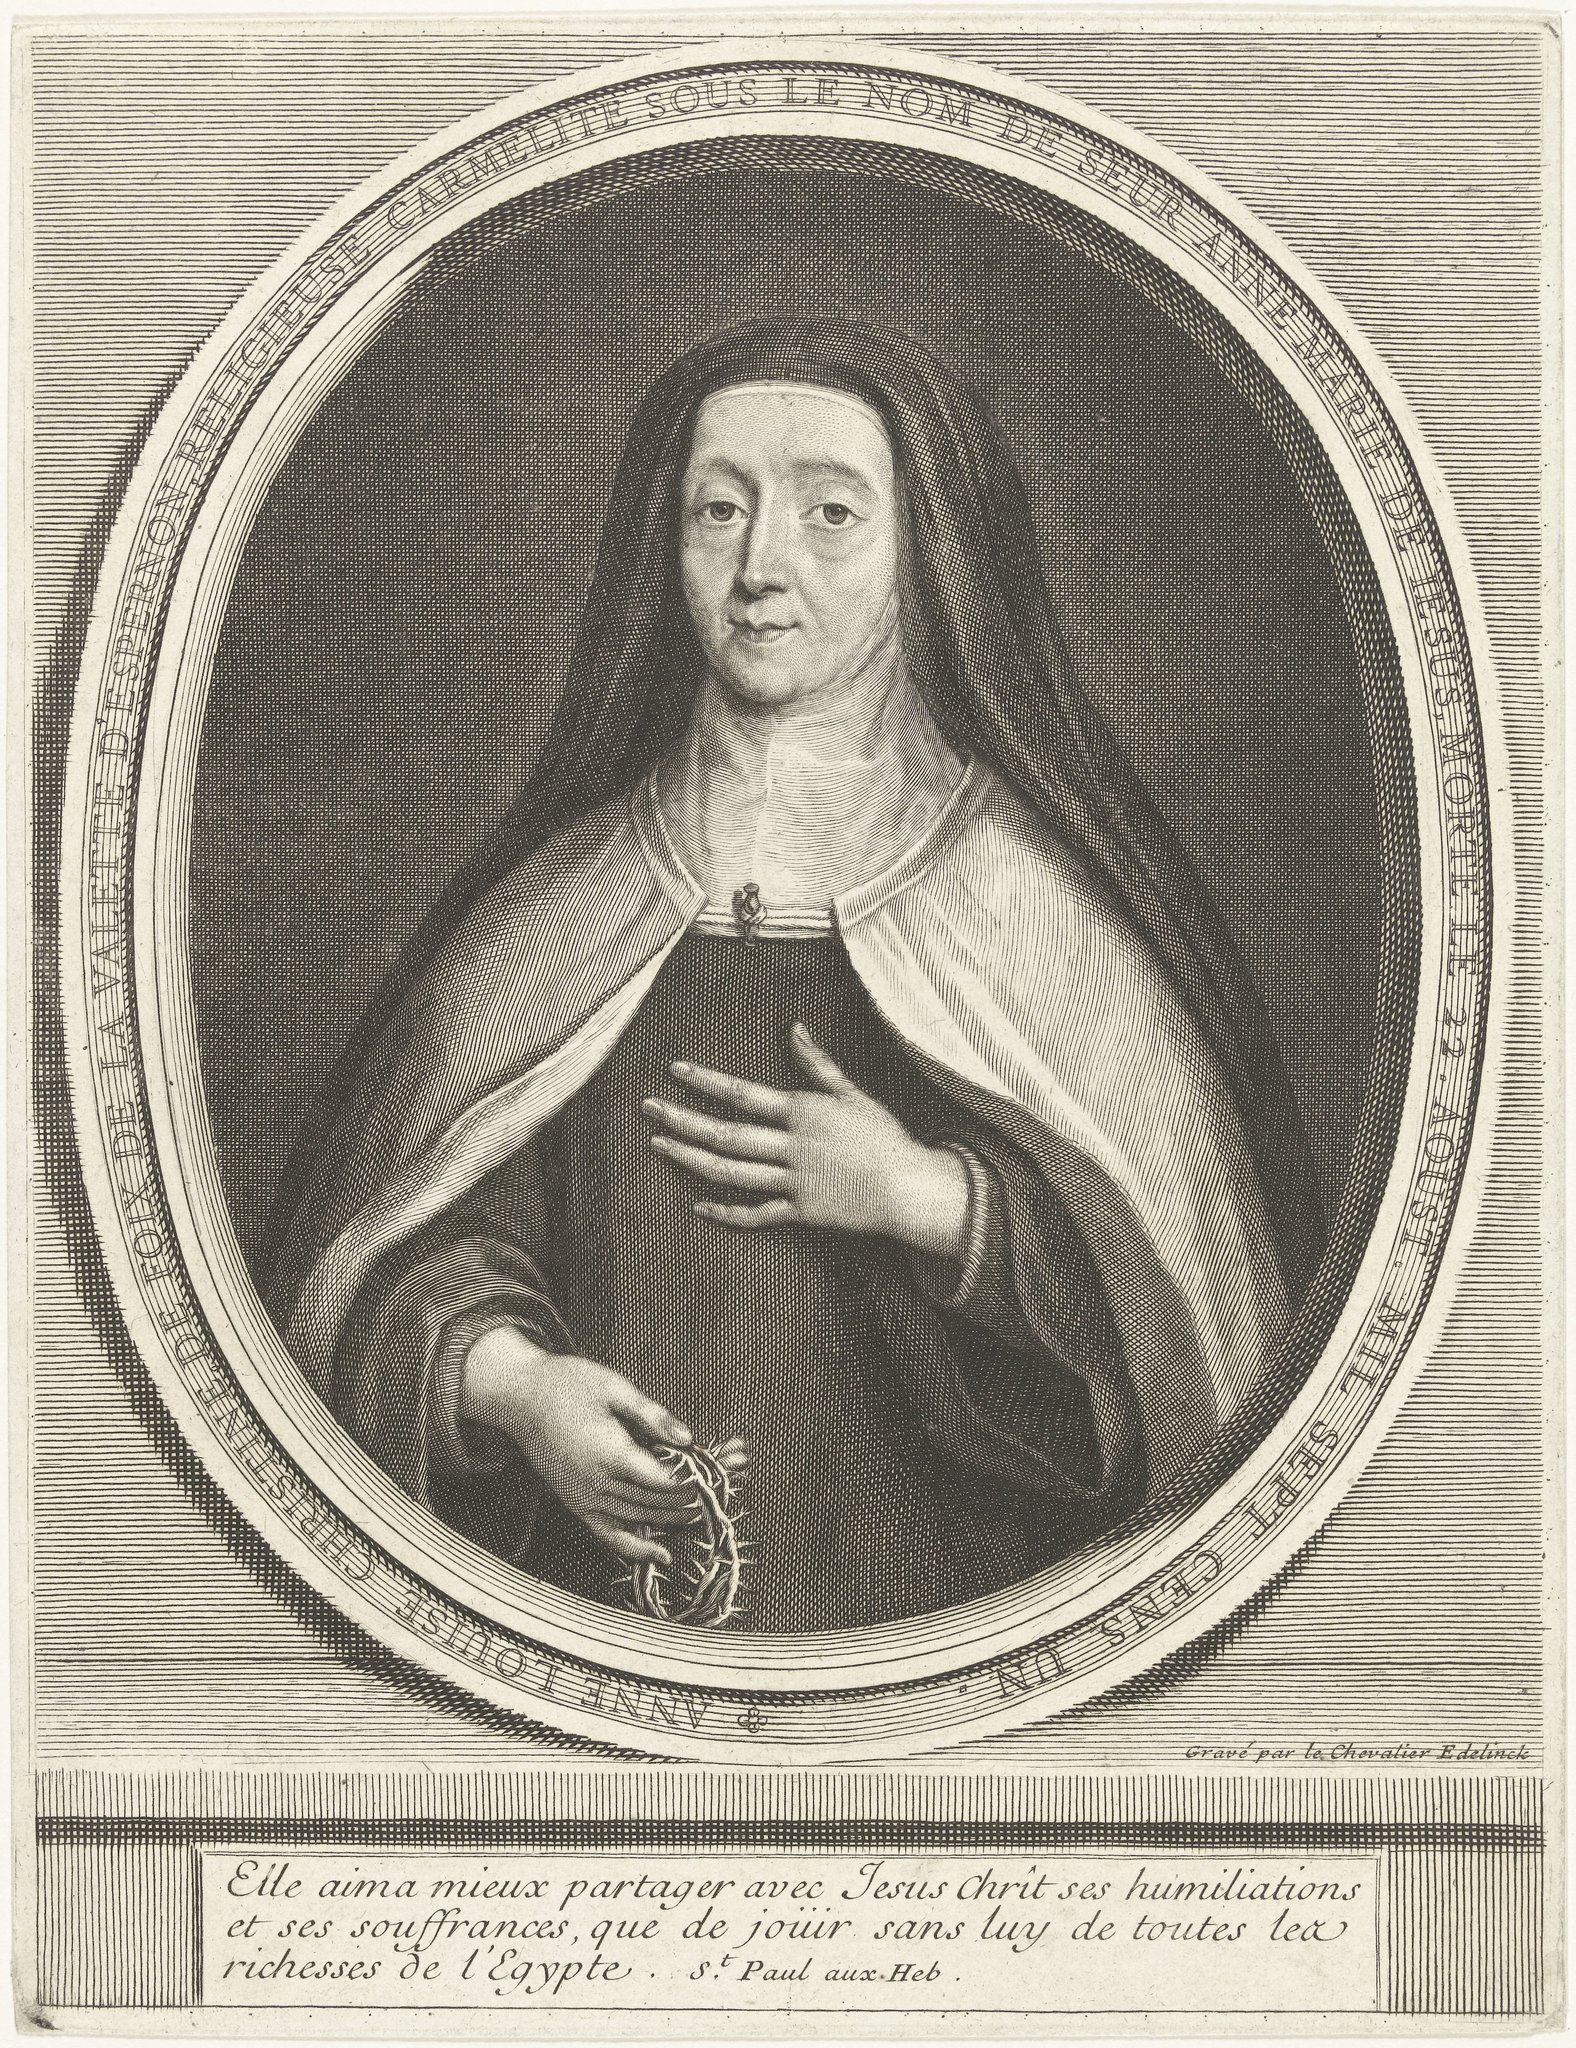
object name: print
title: Portret van Anne-Louise-Christine de Foix de la Valette d'Epernon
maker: gerard edelinck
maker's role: print maker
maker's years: 1640-1707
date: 1652-1707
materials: paper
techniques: engraving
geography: france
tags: france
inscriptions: collector's mark: Lugt 2228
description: Portret ten halven lijve van Karmelietes zuster Anne-Louise-Christine de Foix de la Valette d'Epernon (1622-1701). Afgebeeld met doornenkrans in rechter hand, in ovale omlijsting met tekst, waaronder drie regels Latijn.